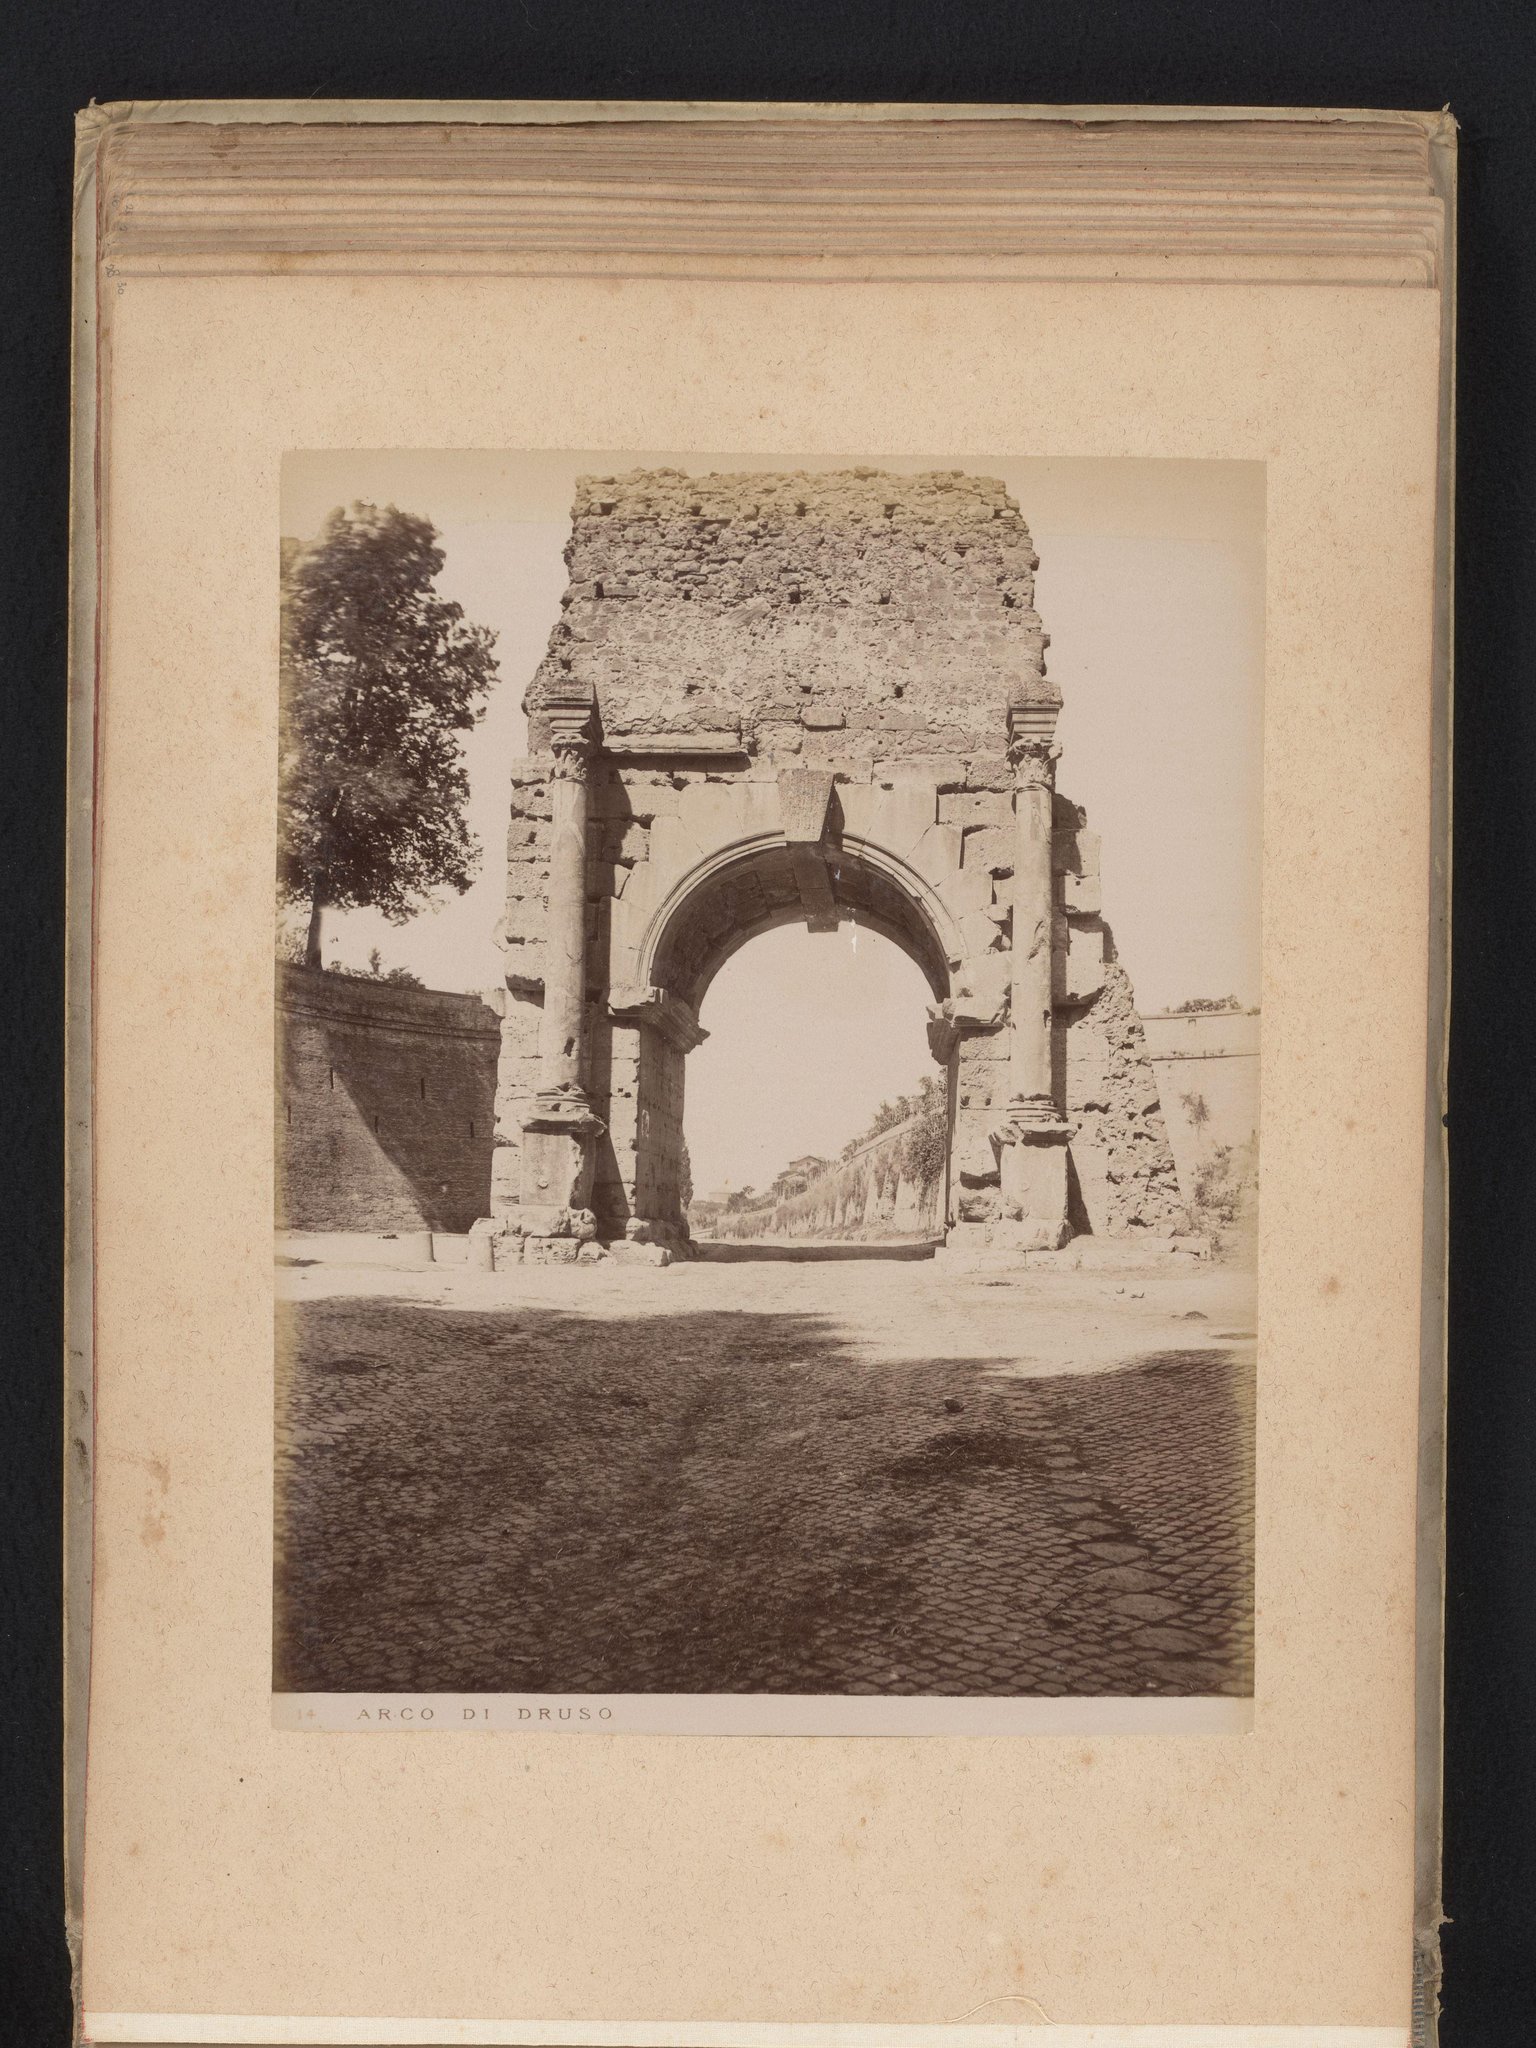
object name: album leaf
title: Gezicht op de Boog van Drusus in Rome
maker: Anonymous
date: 1870-1895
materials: cardboard, photographic support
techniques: albumen print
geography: rome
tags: triumphal arch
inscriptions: inscription: ‘[.]14 ARCO DI DRUSO’